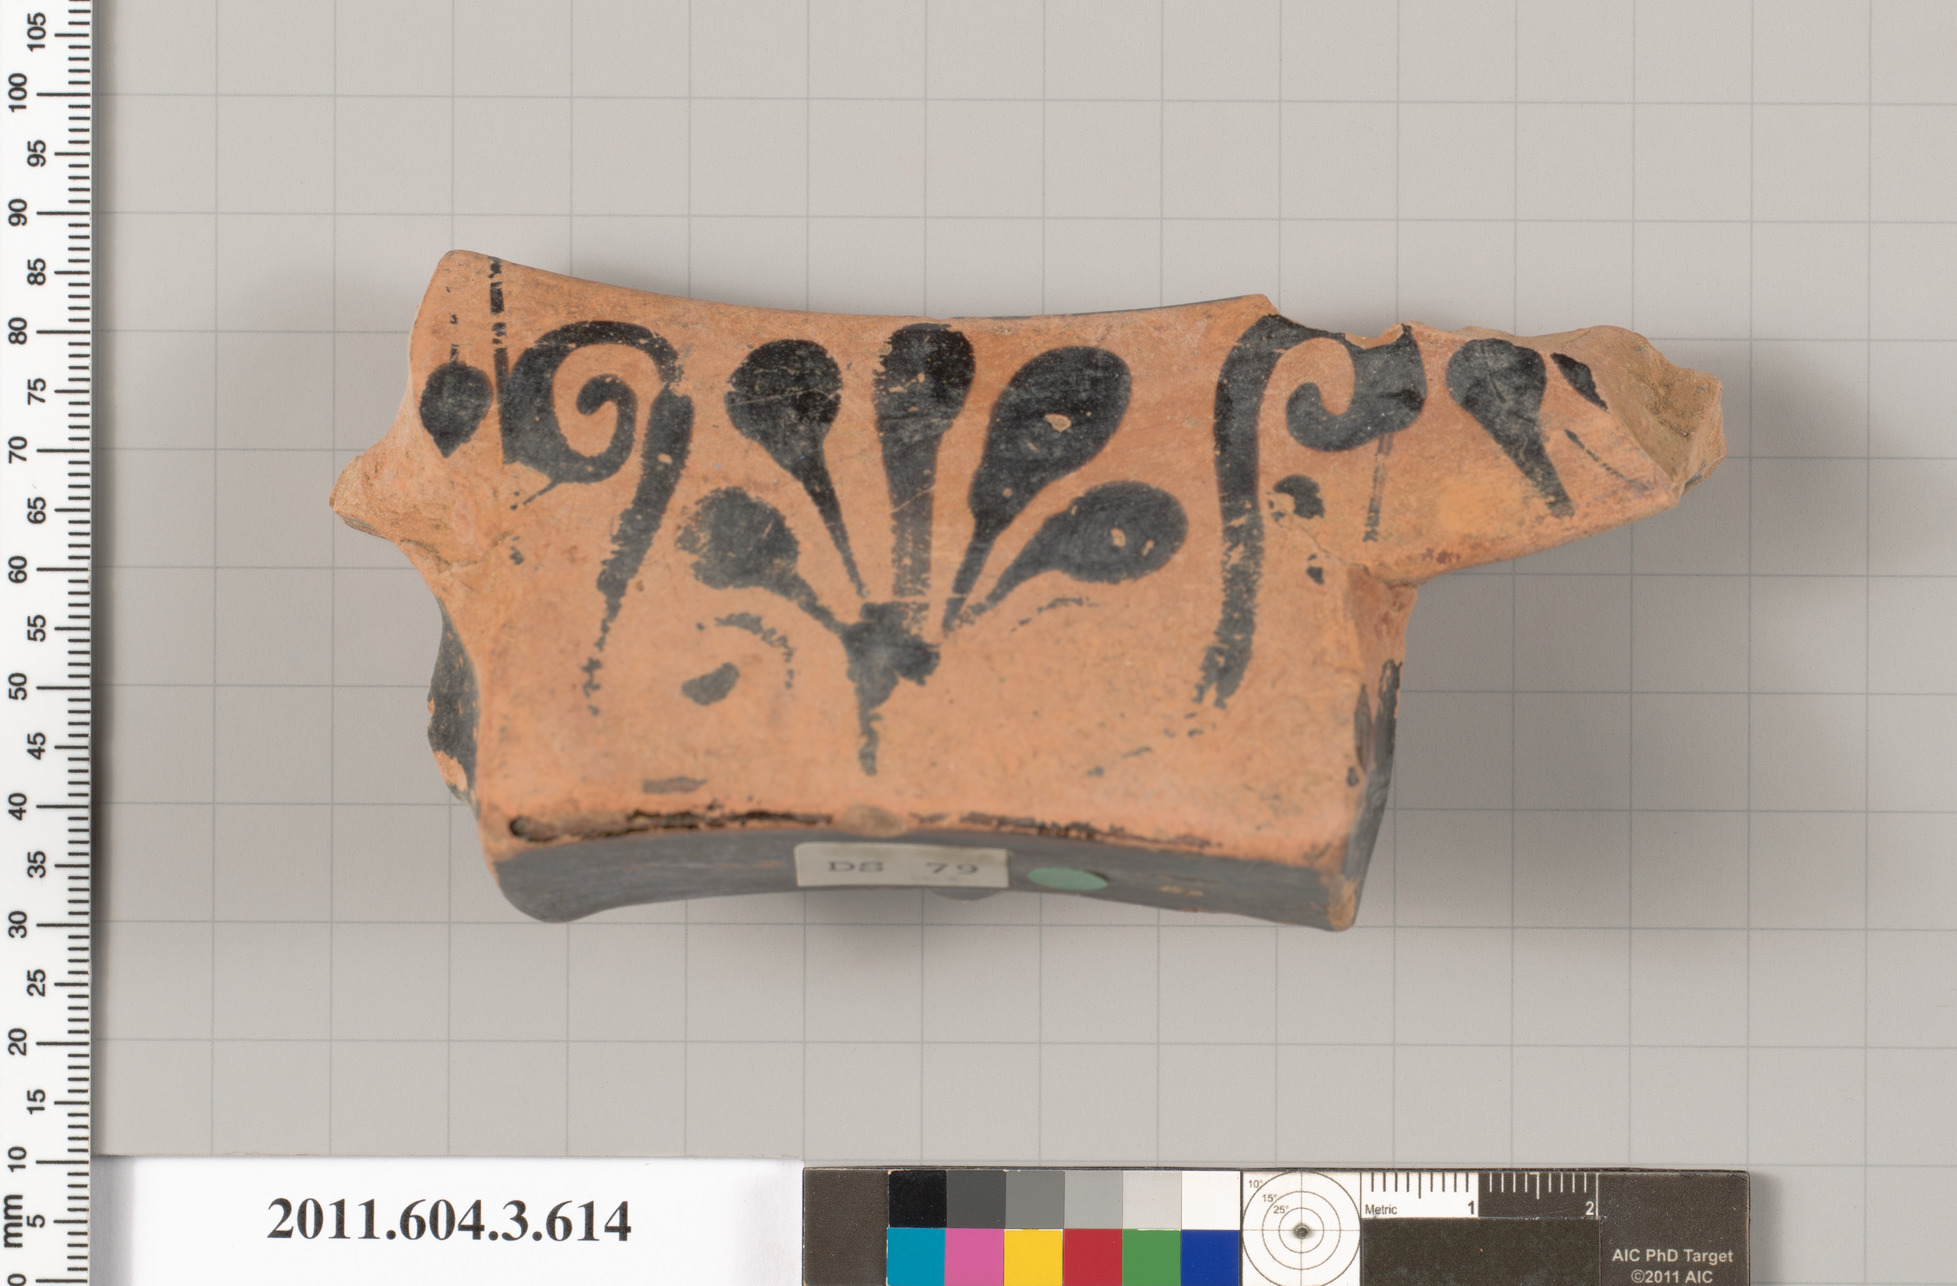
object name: column krater fragment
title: Terracotta fragment of a column-krater (bowl for mixing wine and water)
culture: greek, attic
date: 510-500 BCE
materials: terracotta